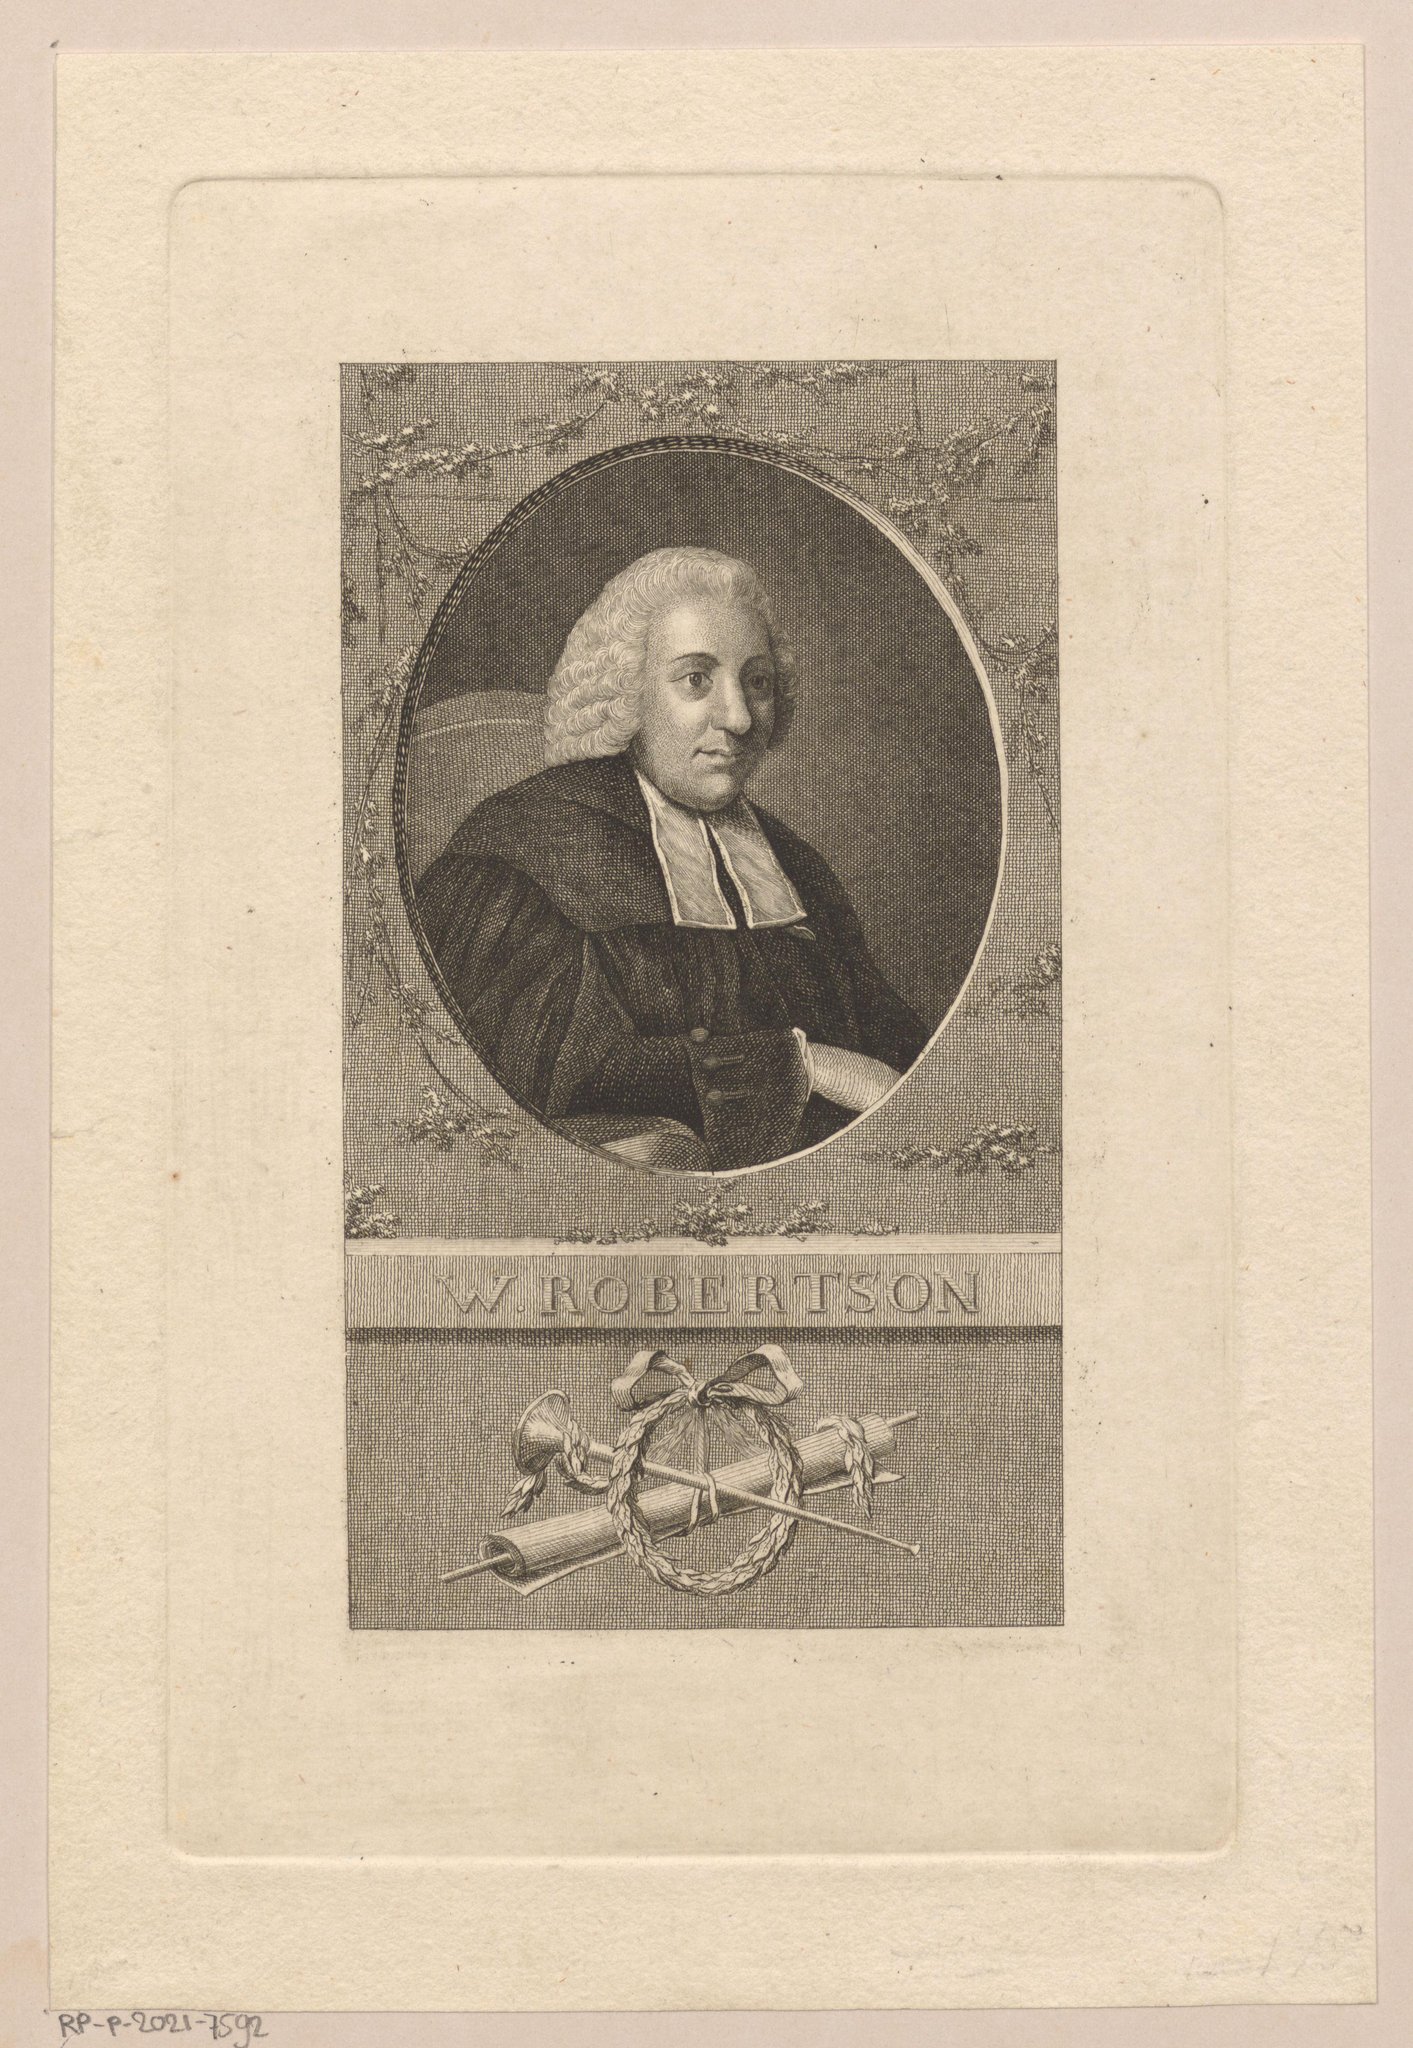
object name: print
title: Portret van William Robertson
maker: Anonymous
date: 1750-1849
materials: paper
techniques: etching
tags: horn, trumpet, cornet, trombone, tuba, historical persons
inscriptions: collector's mark: Lugt 240